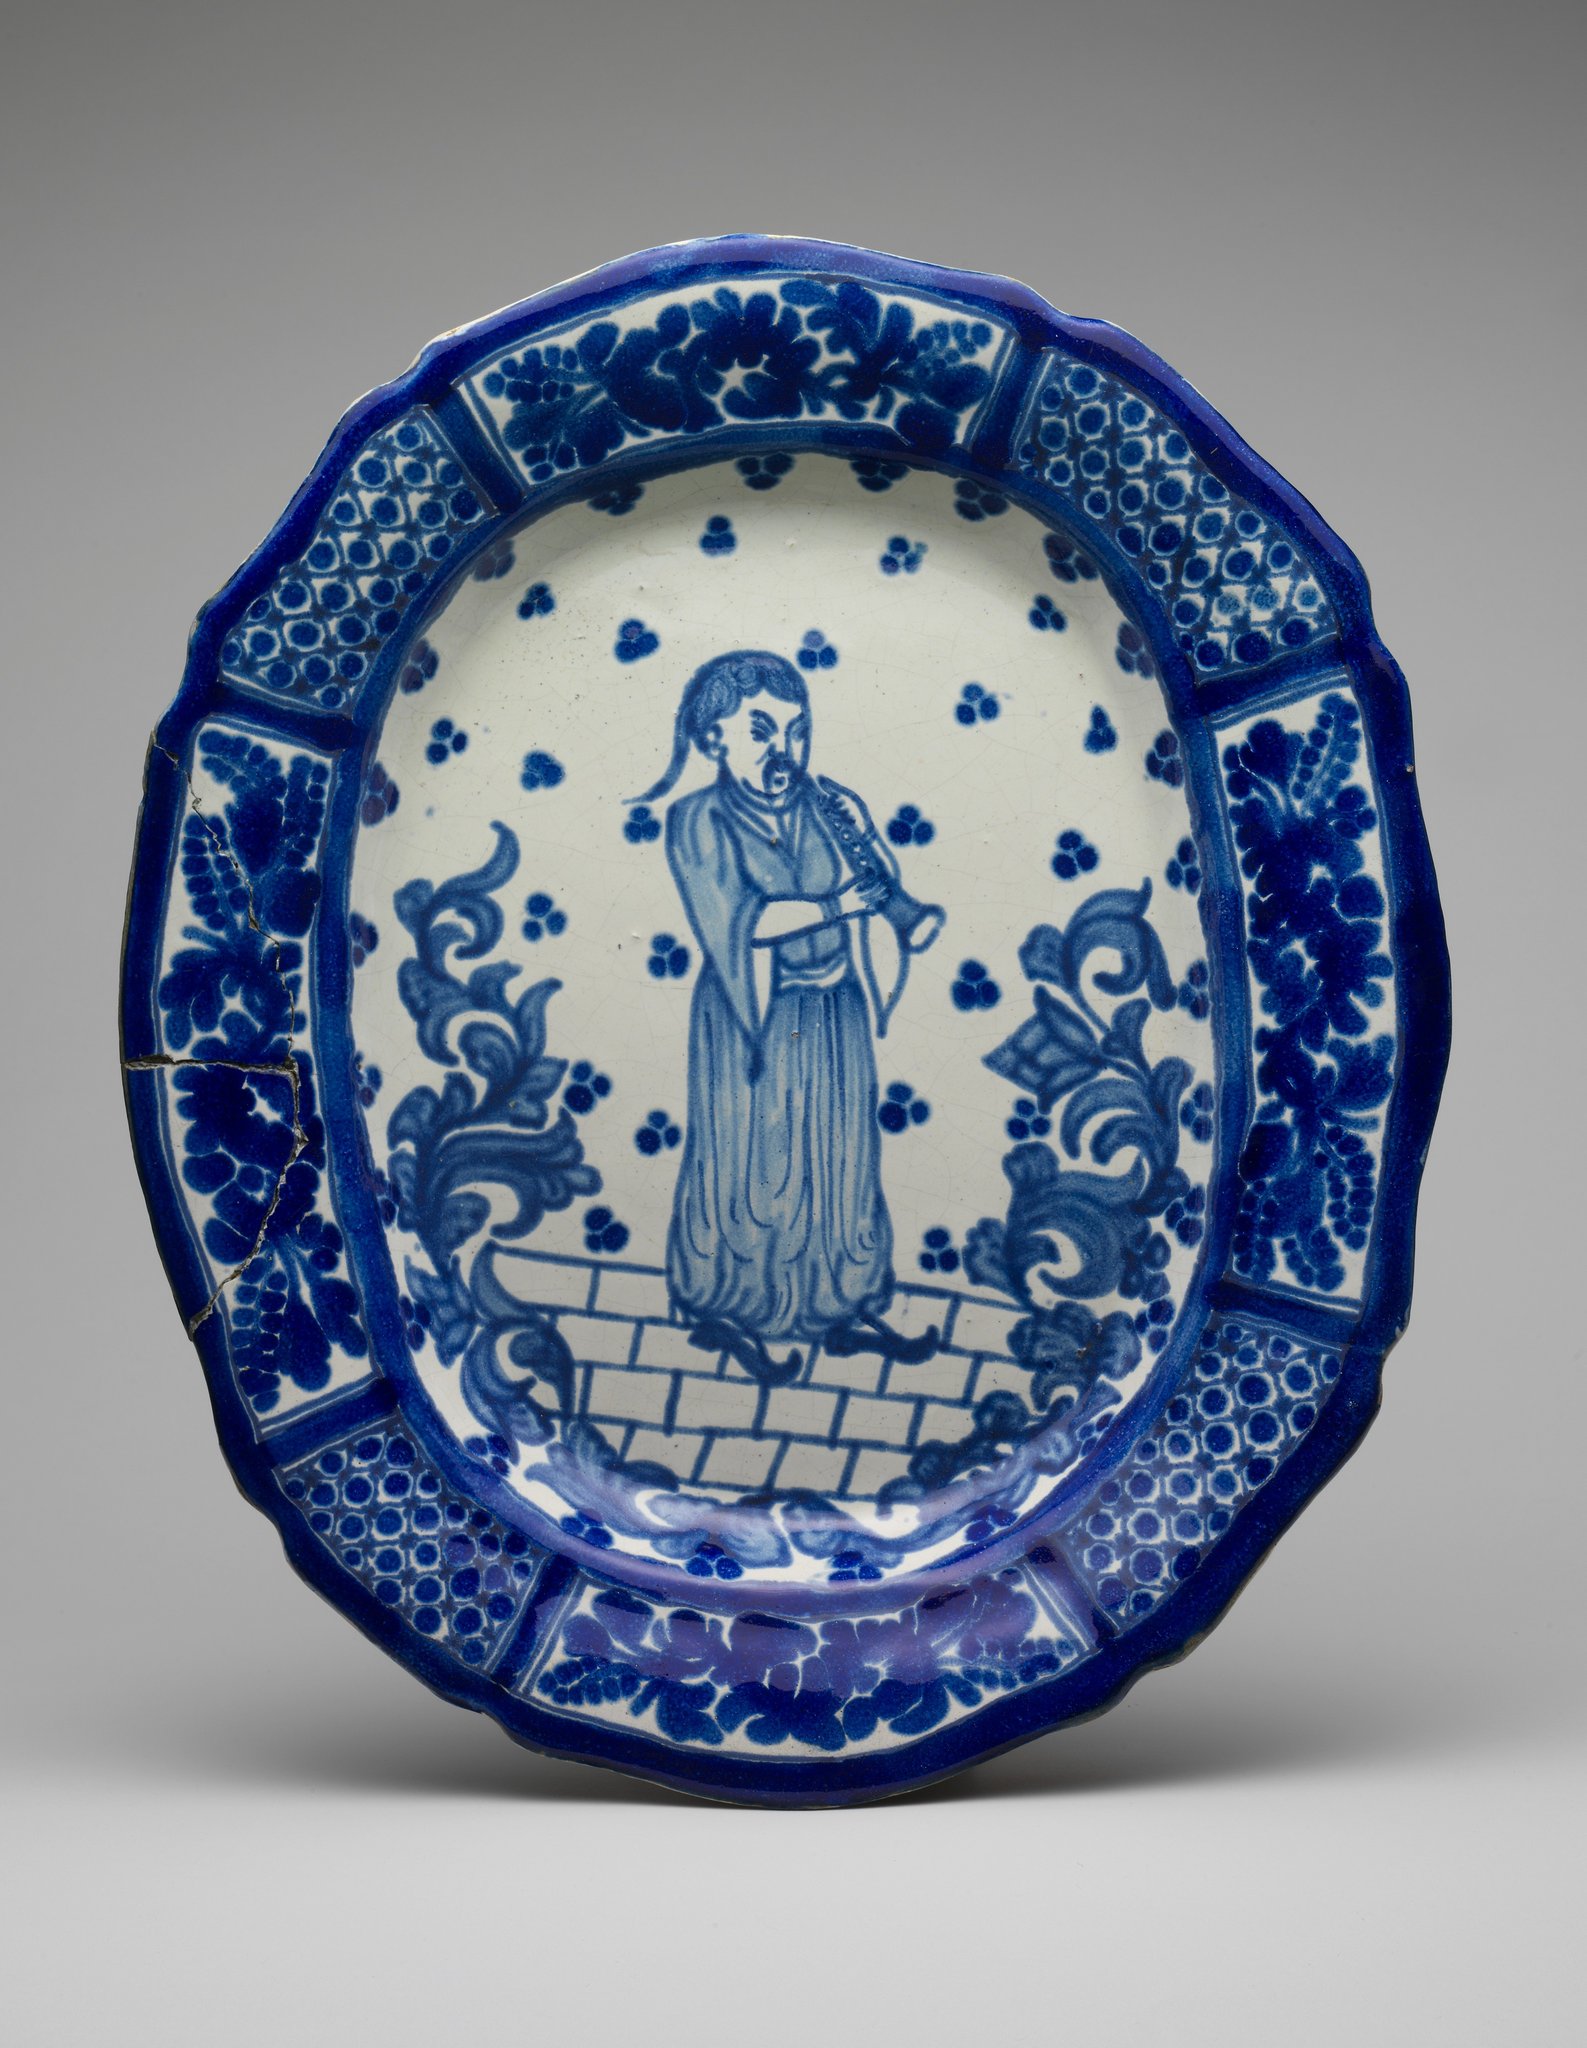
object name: dish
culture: mexican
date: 1830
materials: earthenware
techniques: glazing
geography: mexico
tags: musical instruments,men,musicians